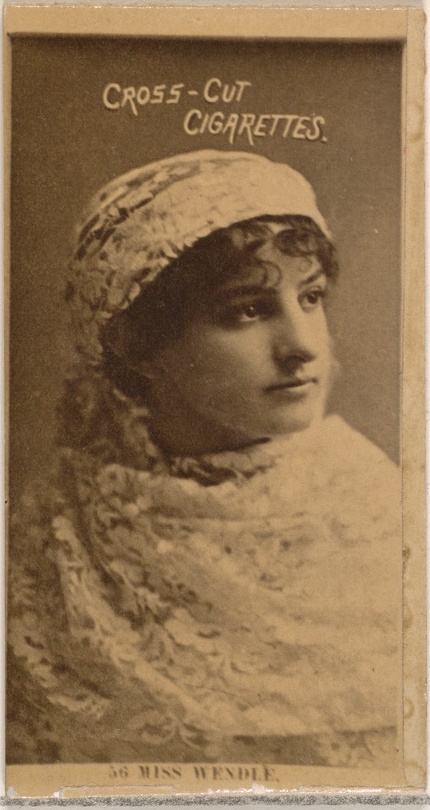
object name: print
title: Card Number 56, Miss Wendle, from the Actors and Actresses series (N145-2) issued by Duke Sons & Co. to promote Cross Cut Cigarettes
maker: w. duke, sons & co.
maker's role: publisher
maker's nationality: american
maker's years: 1870-1920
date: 1880-1889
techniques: albumen silver print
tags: portraits,women,actresses